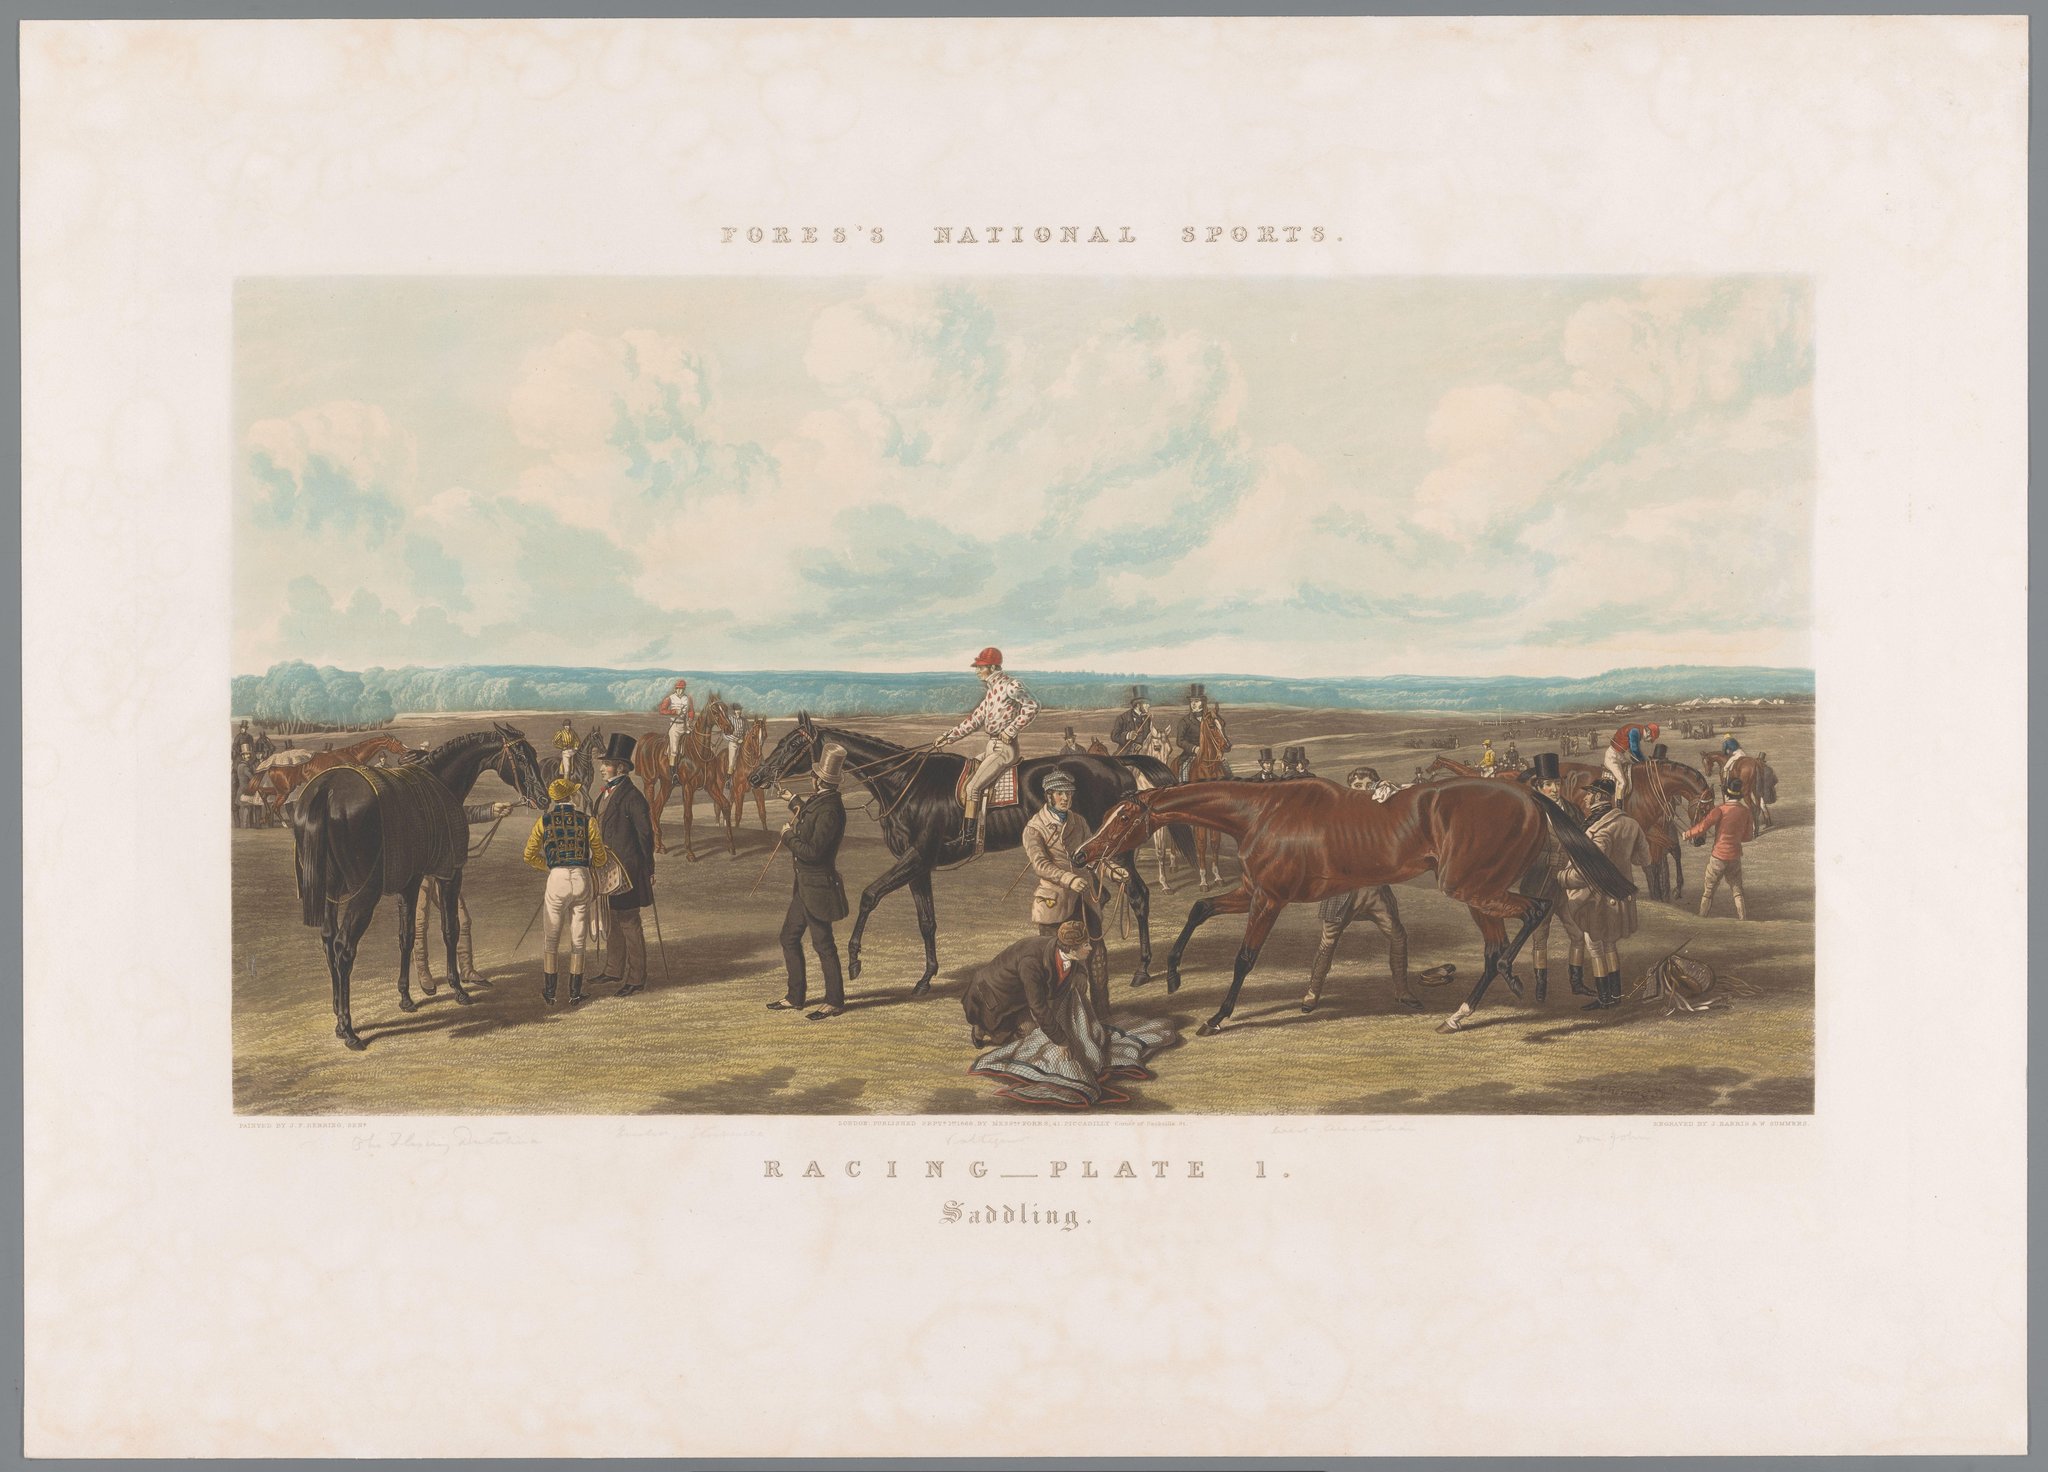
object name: print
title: Fore's National Sports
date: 1866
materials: paper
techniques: aquatint, etching, hand coloring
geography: london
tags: horse-racing, race-track, jockey, saddle, england